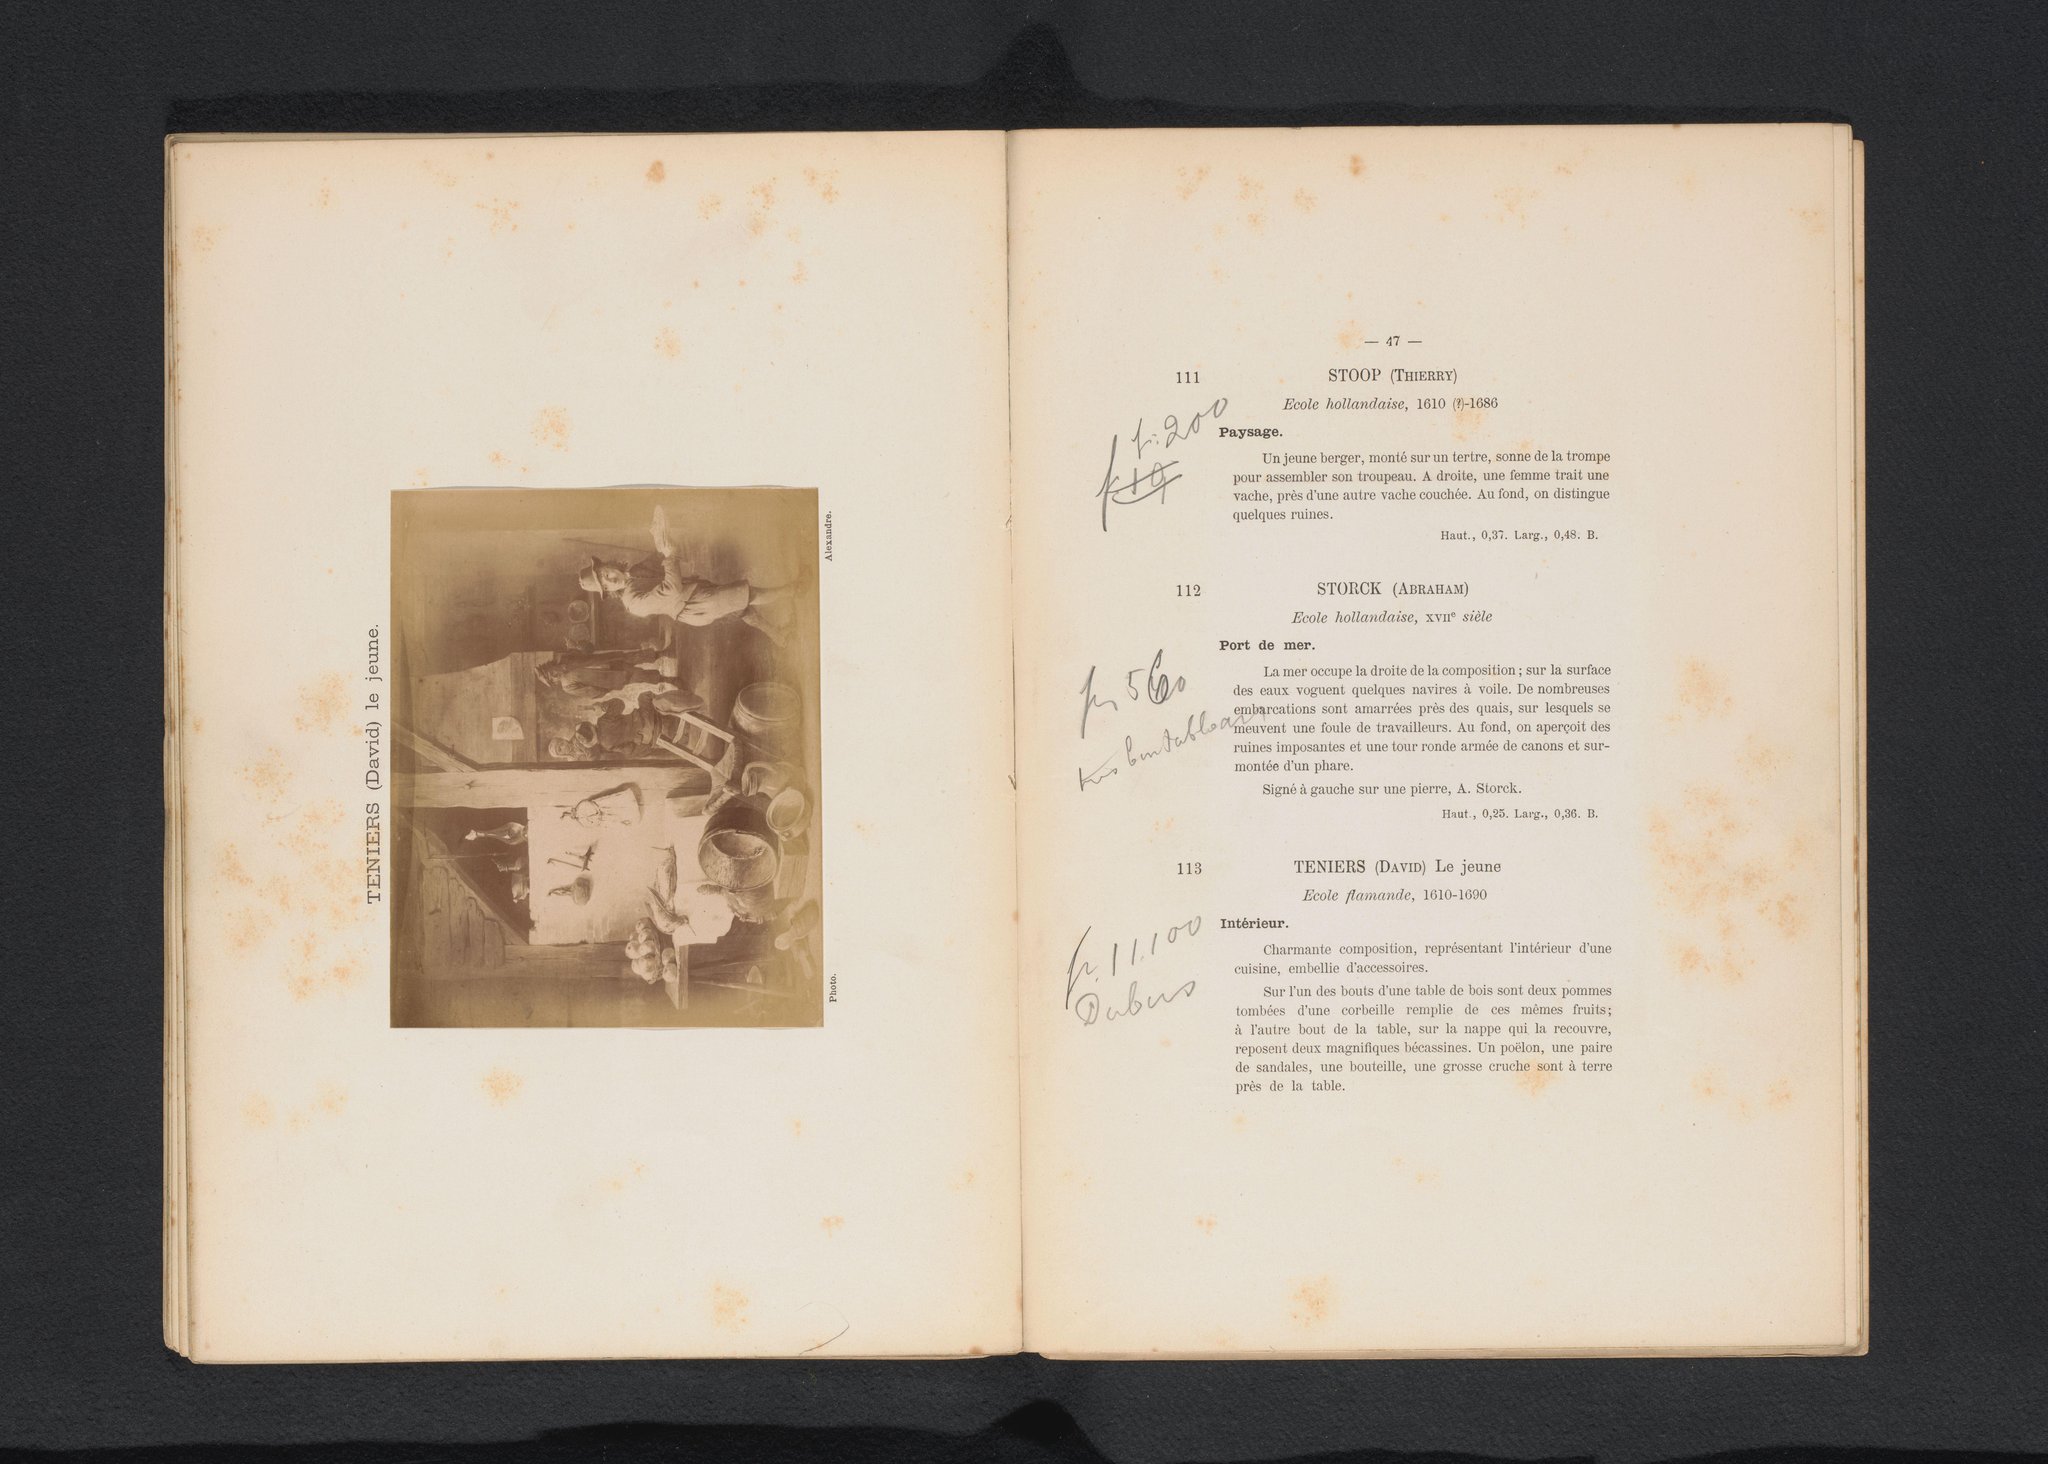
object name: photograph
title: Fotoreproductie van een schilderij van een jongen in een keuken met op de achtergrond drie personen, door David Teniers II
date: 1886-1891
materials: photographic support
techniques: albumen print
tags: youth, adolescent, kitchen-interior